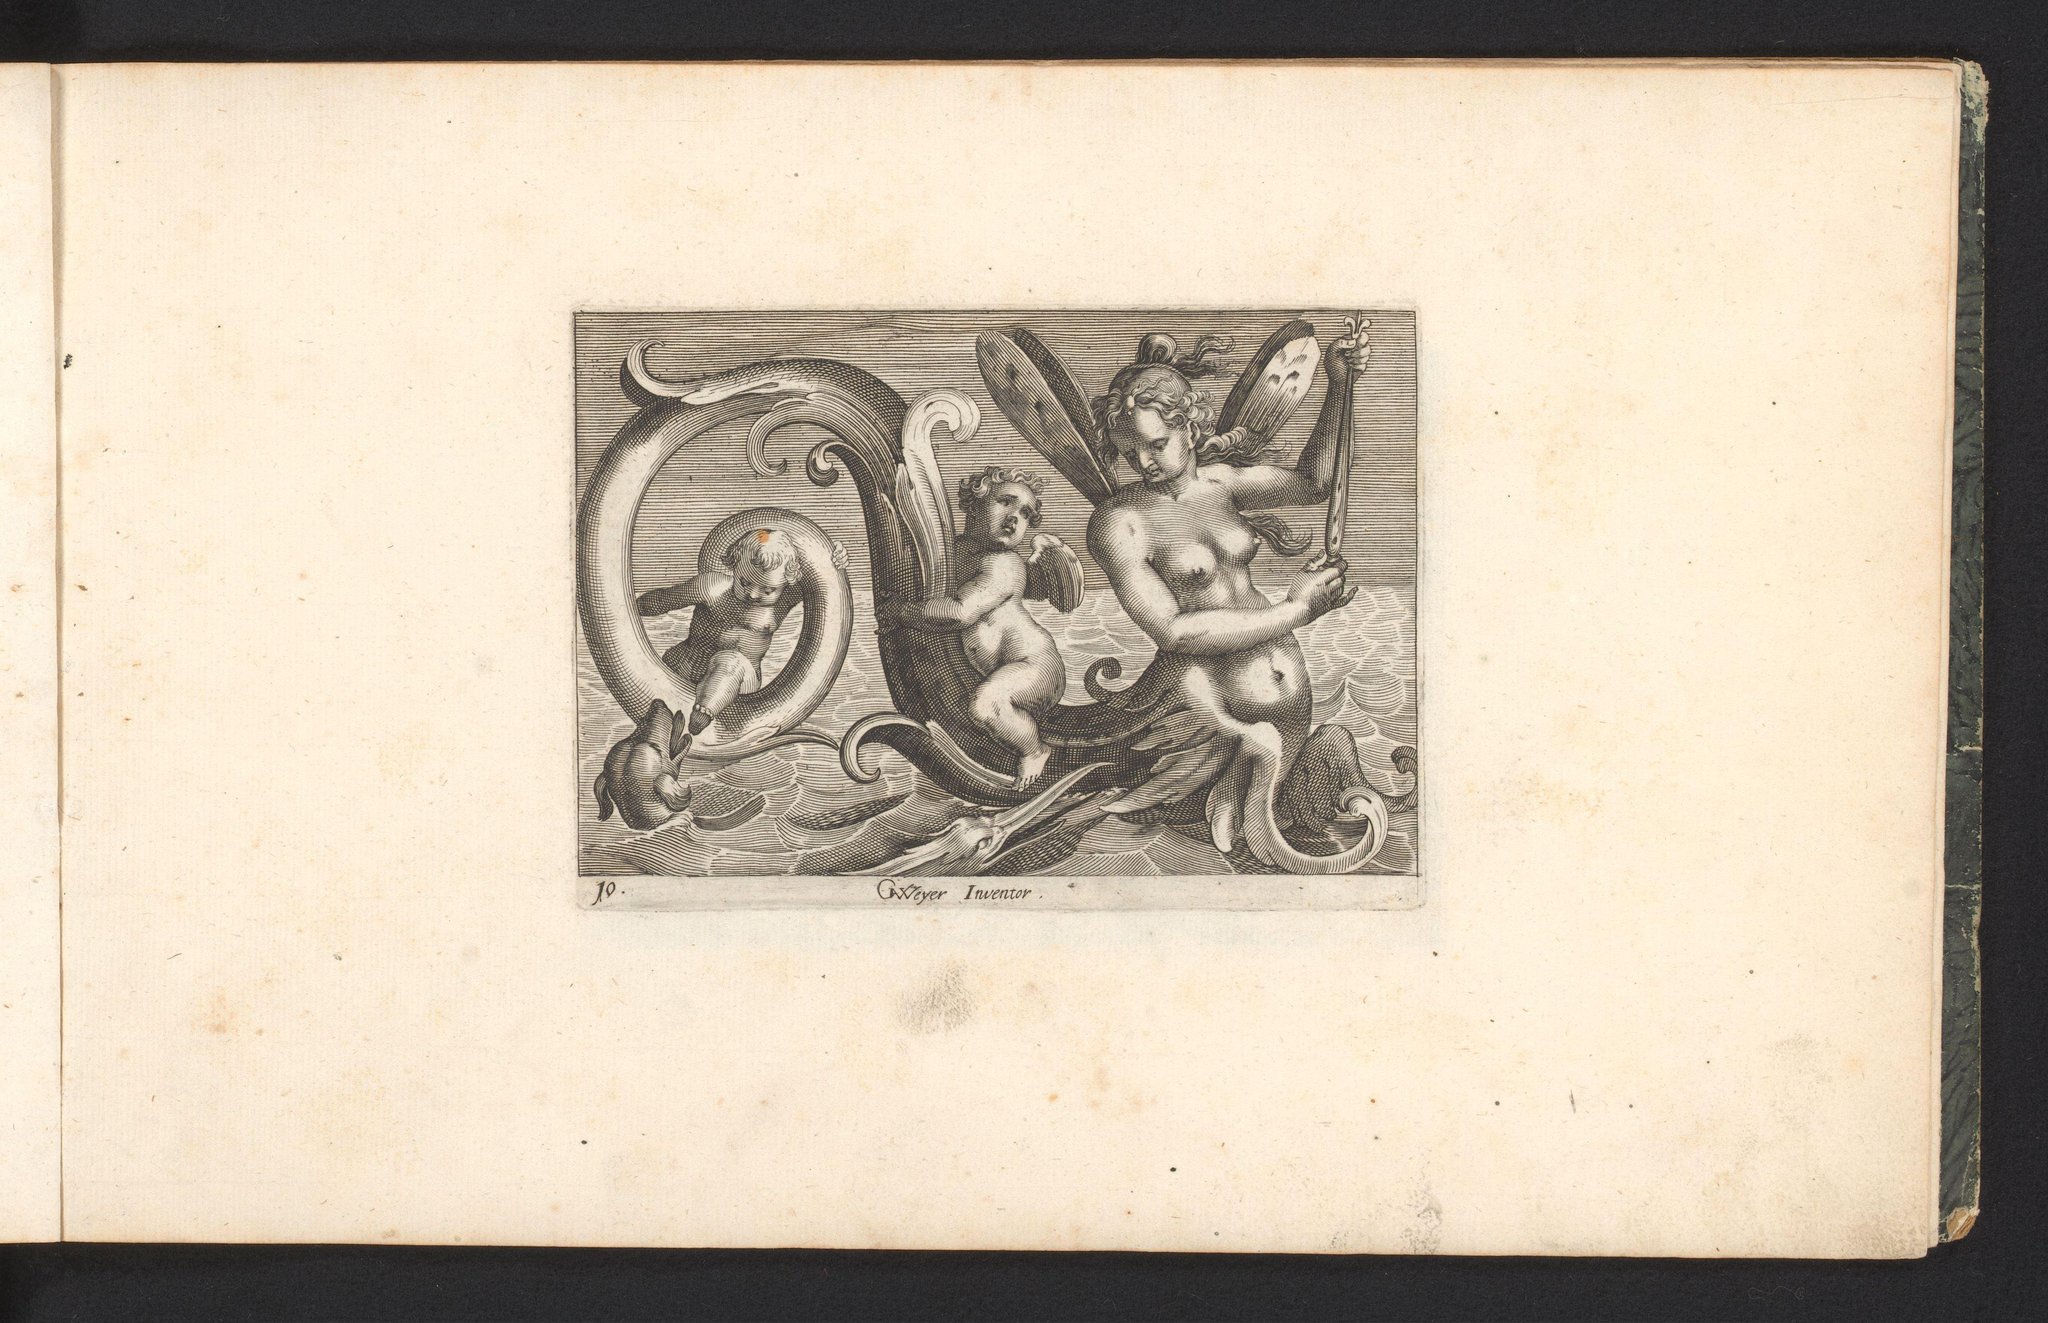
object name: ornament print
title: Monstra Marina / Meehr Wunder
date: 1571-1635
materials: paper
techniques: engraving, etching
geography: nuremberg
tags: monsters of the sea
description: Een zeenimf met een vissenstaart en twee putti.